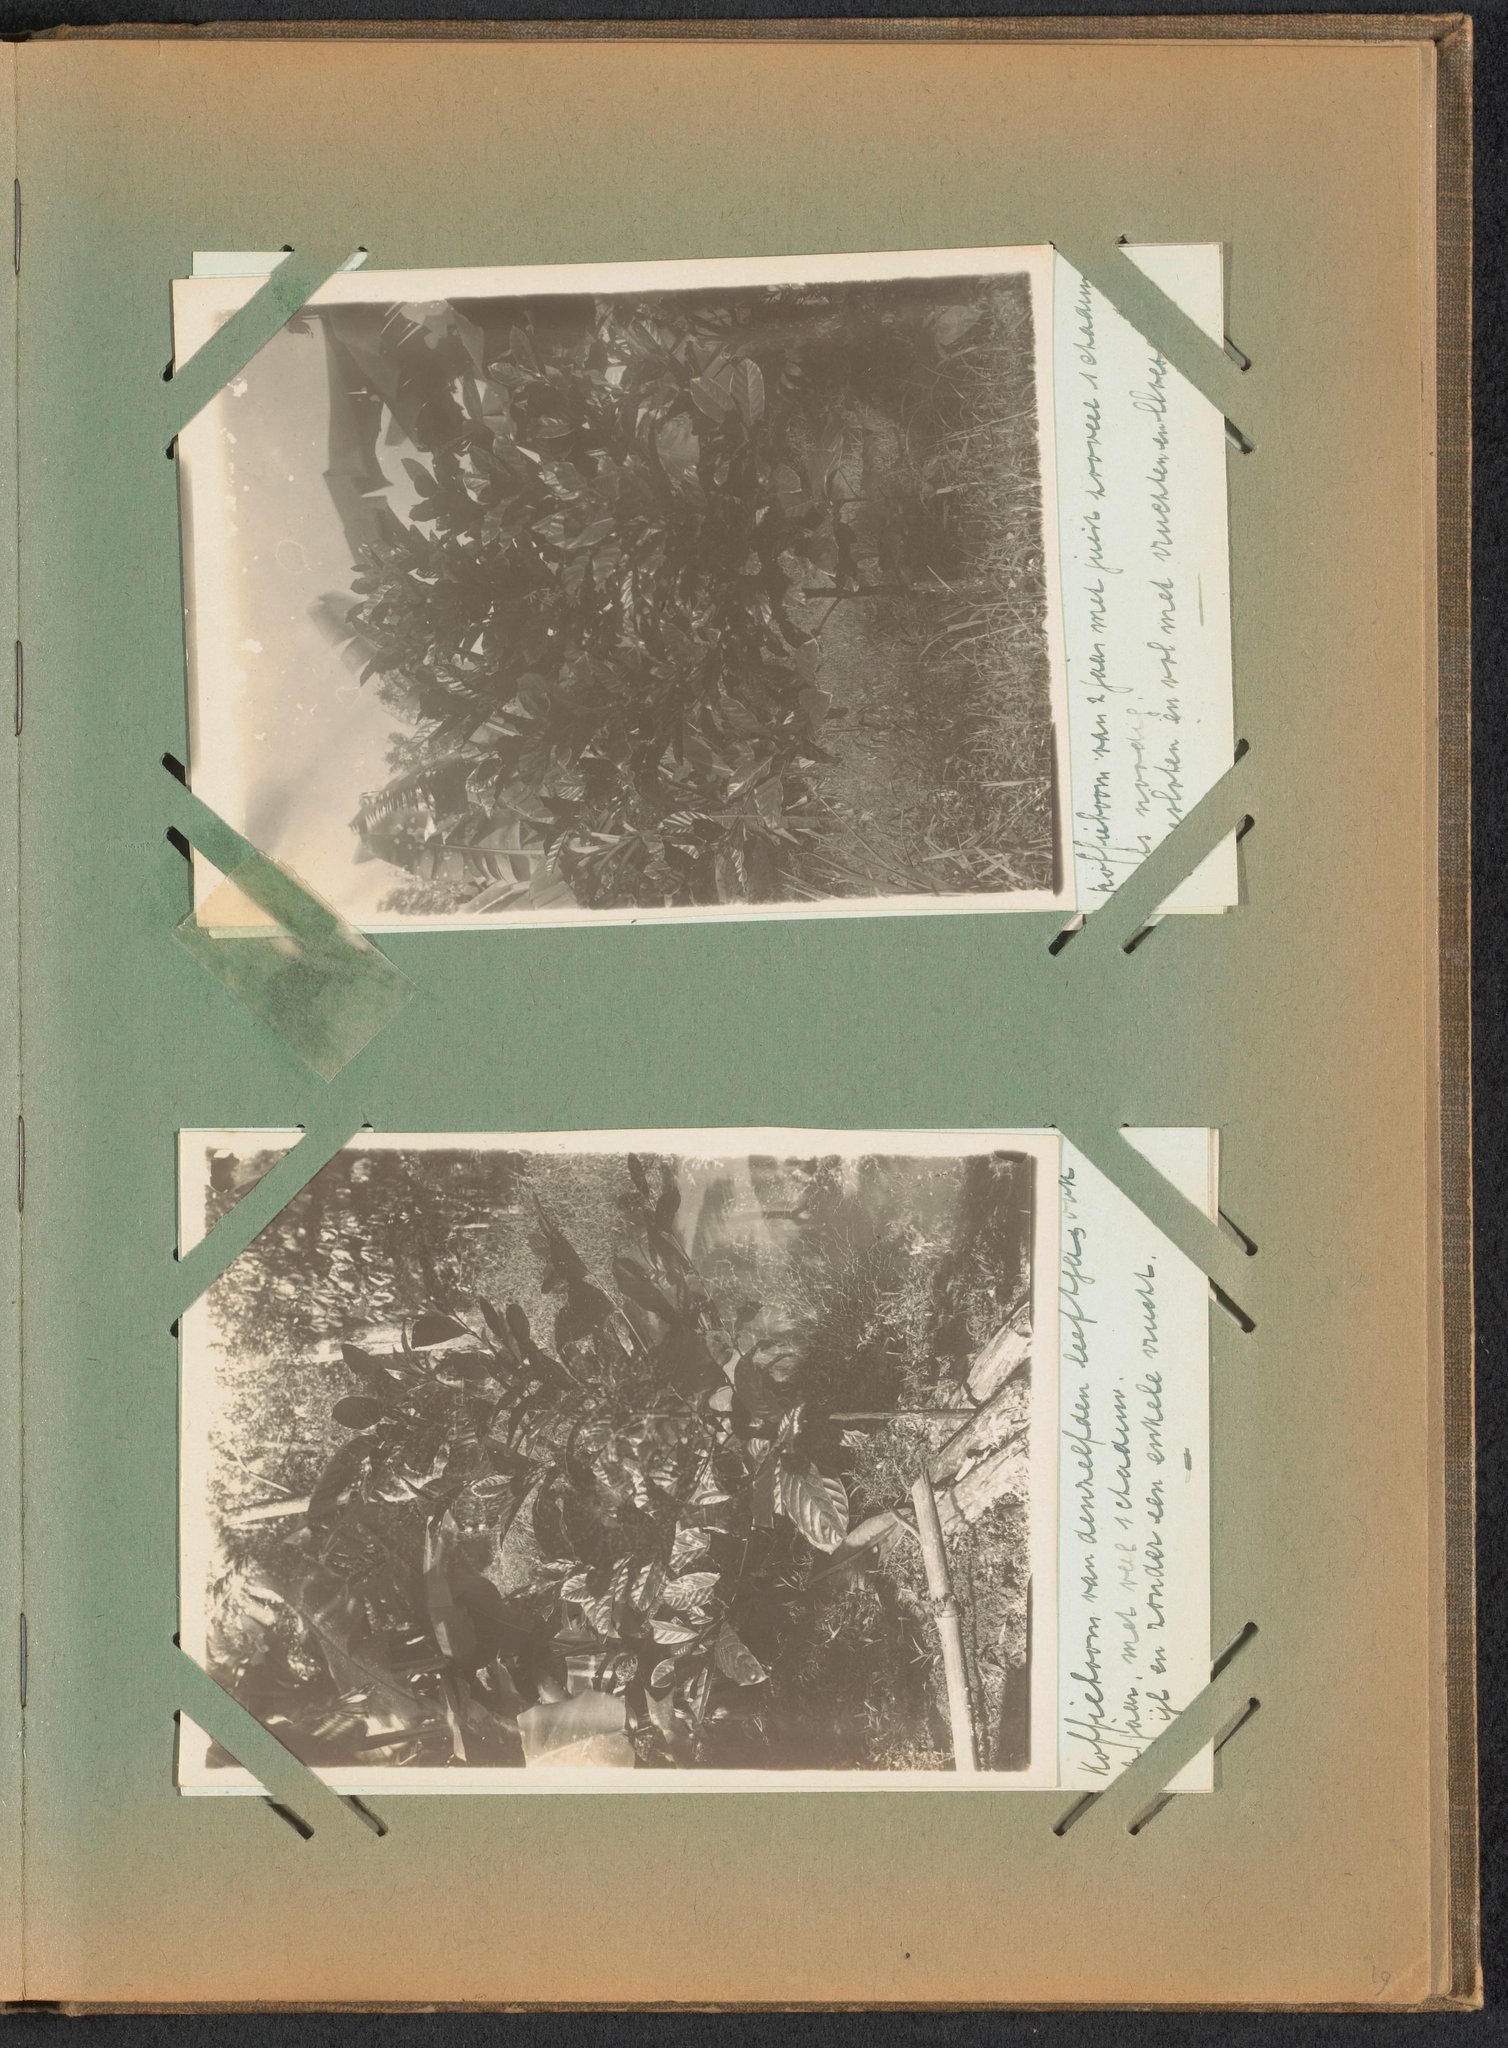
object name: photograph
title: Koffiebomen op Plantage Peperpot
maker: Anonymous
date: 1912-1913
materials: paper, photographic support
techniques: gelatin silver print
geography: suriname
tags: plantation, fruits: coffee, suriname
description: Koffiebomen op Plantage Peperpot in Suriname. Onderdeel van het fotoalbum uit ca. 1912-1913 met 92 foto's van de plantages Peperpot en Dordrecht in Suriname en Mount Pleasant op Curaçao.